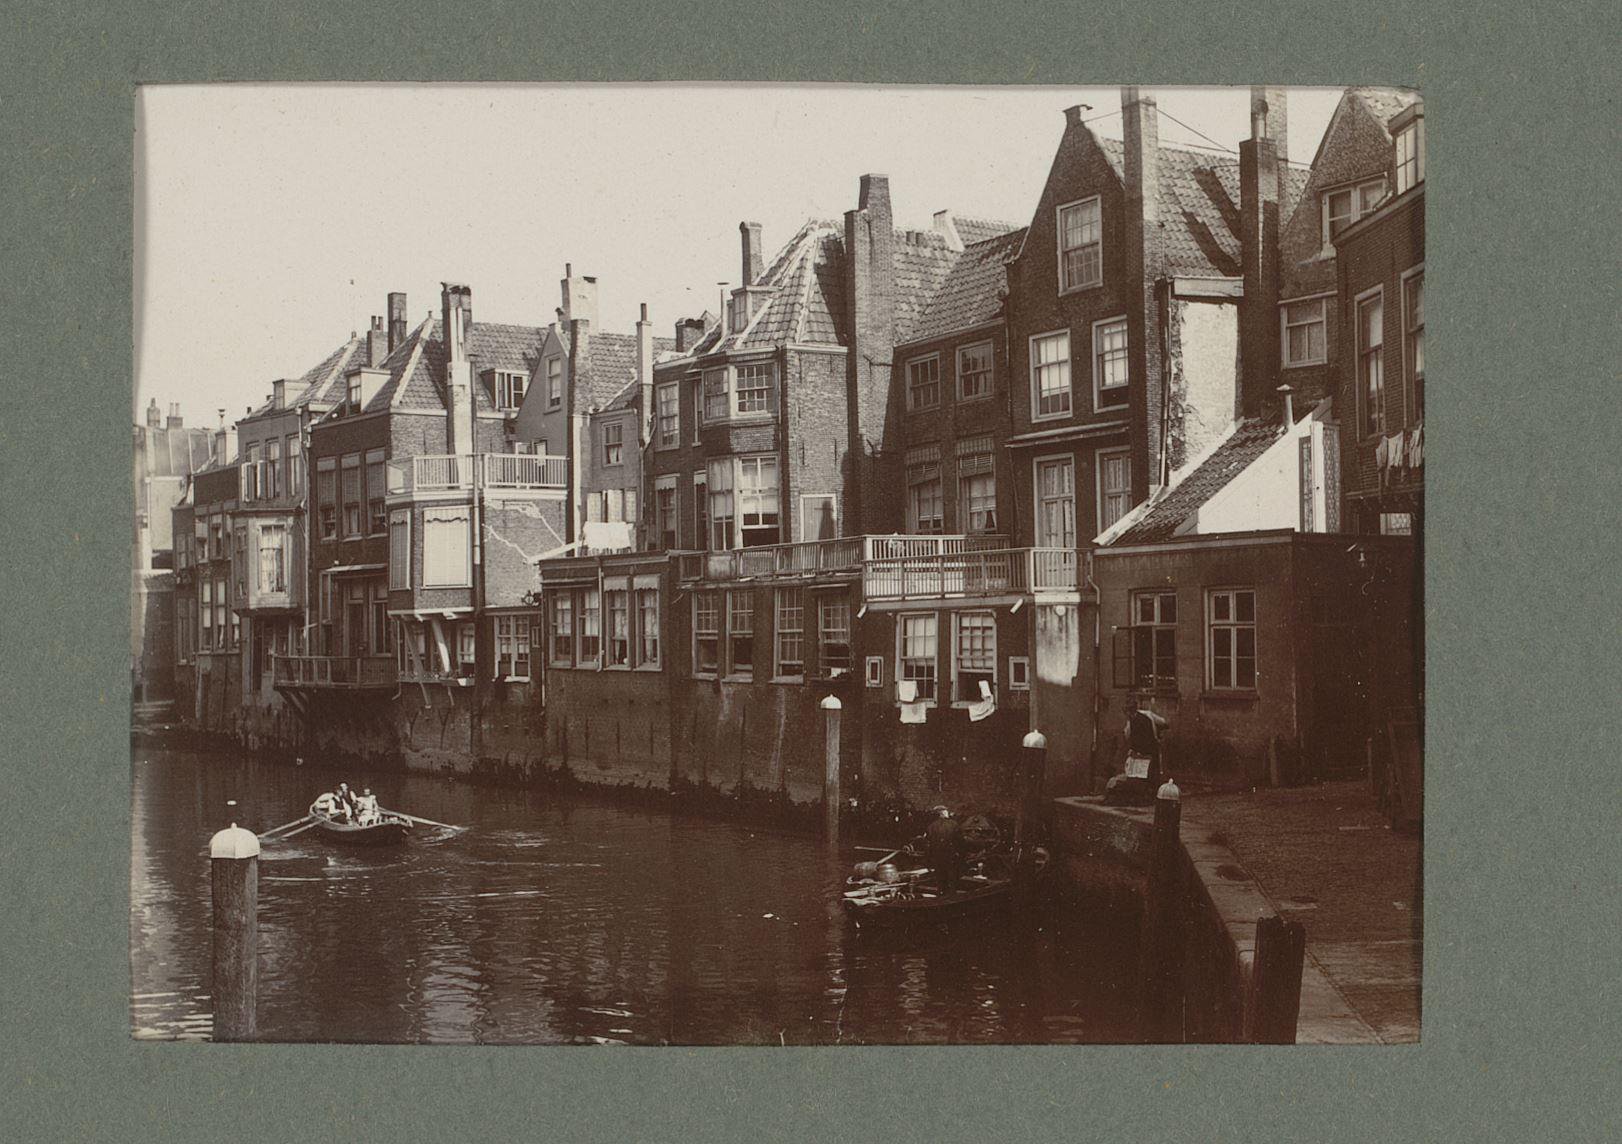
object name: photograph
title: Roeiboten op de Wijnhaven in Dordrecht, gezien vanaf de Wijnbrug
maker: george hidderley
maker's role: fotograaf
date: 1900-1920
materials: photographic support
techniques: gelatin silver print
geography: netherlands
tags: urban housing, rowing-boat, canoe, etc., canals, waters (in city), dordrecht